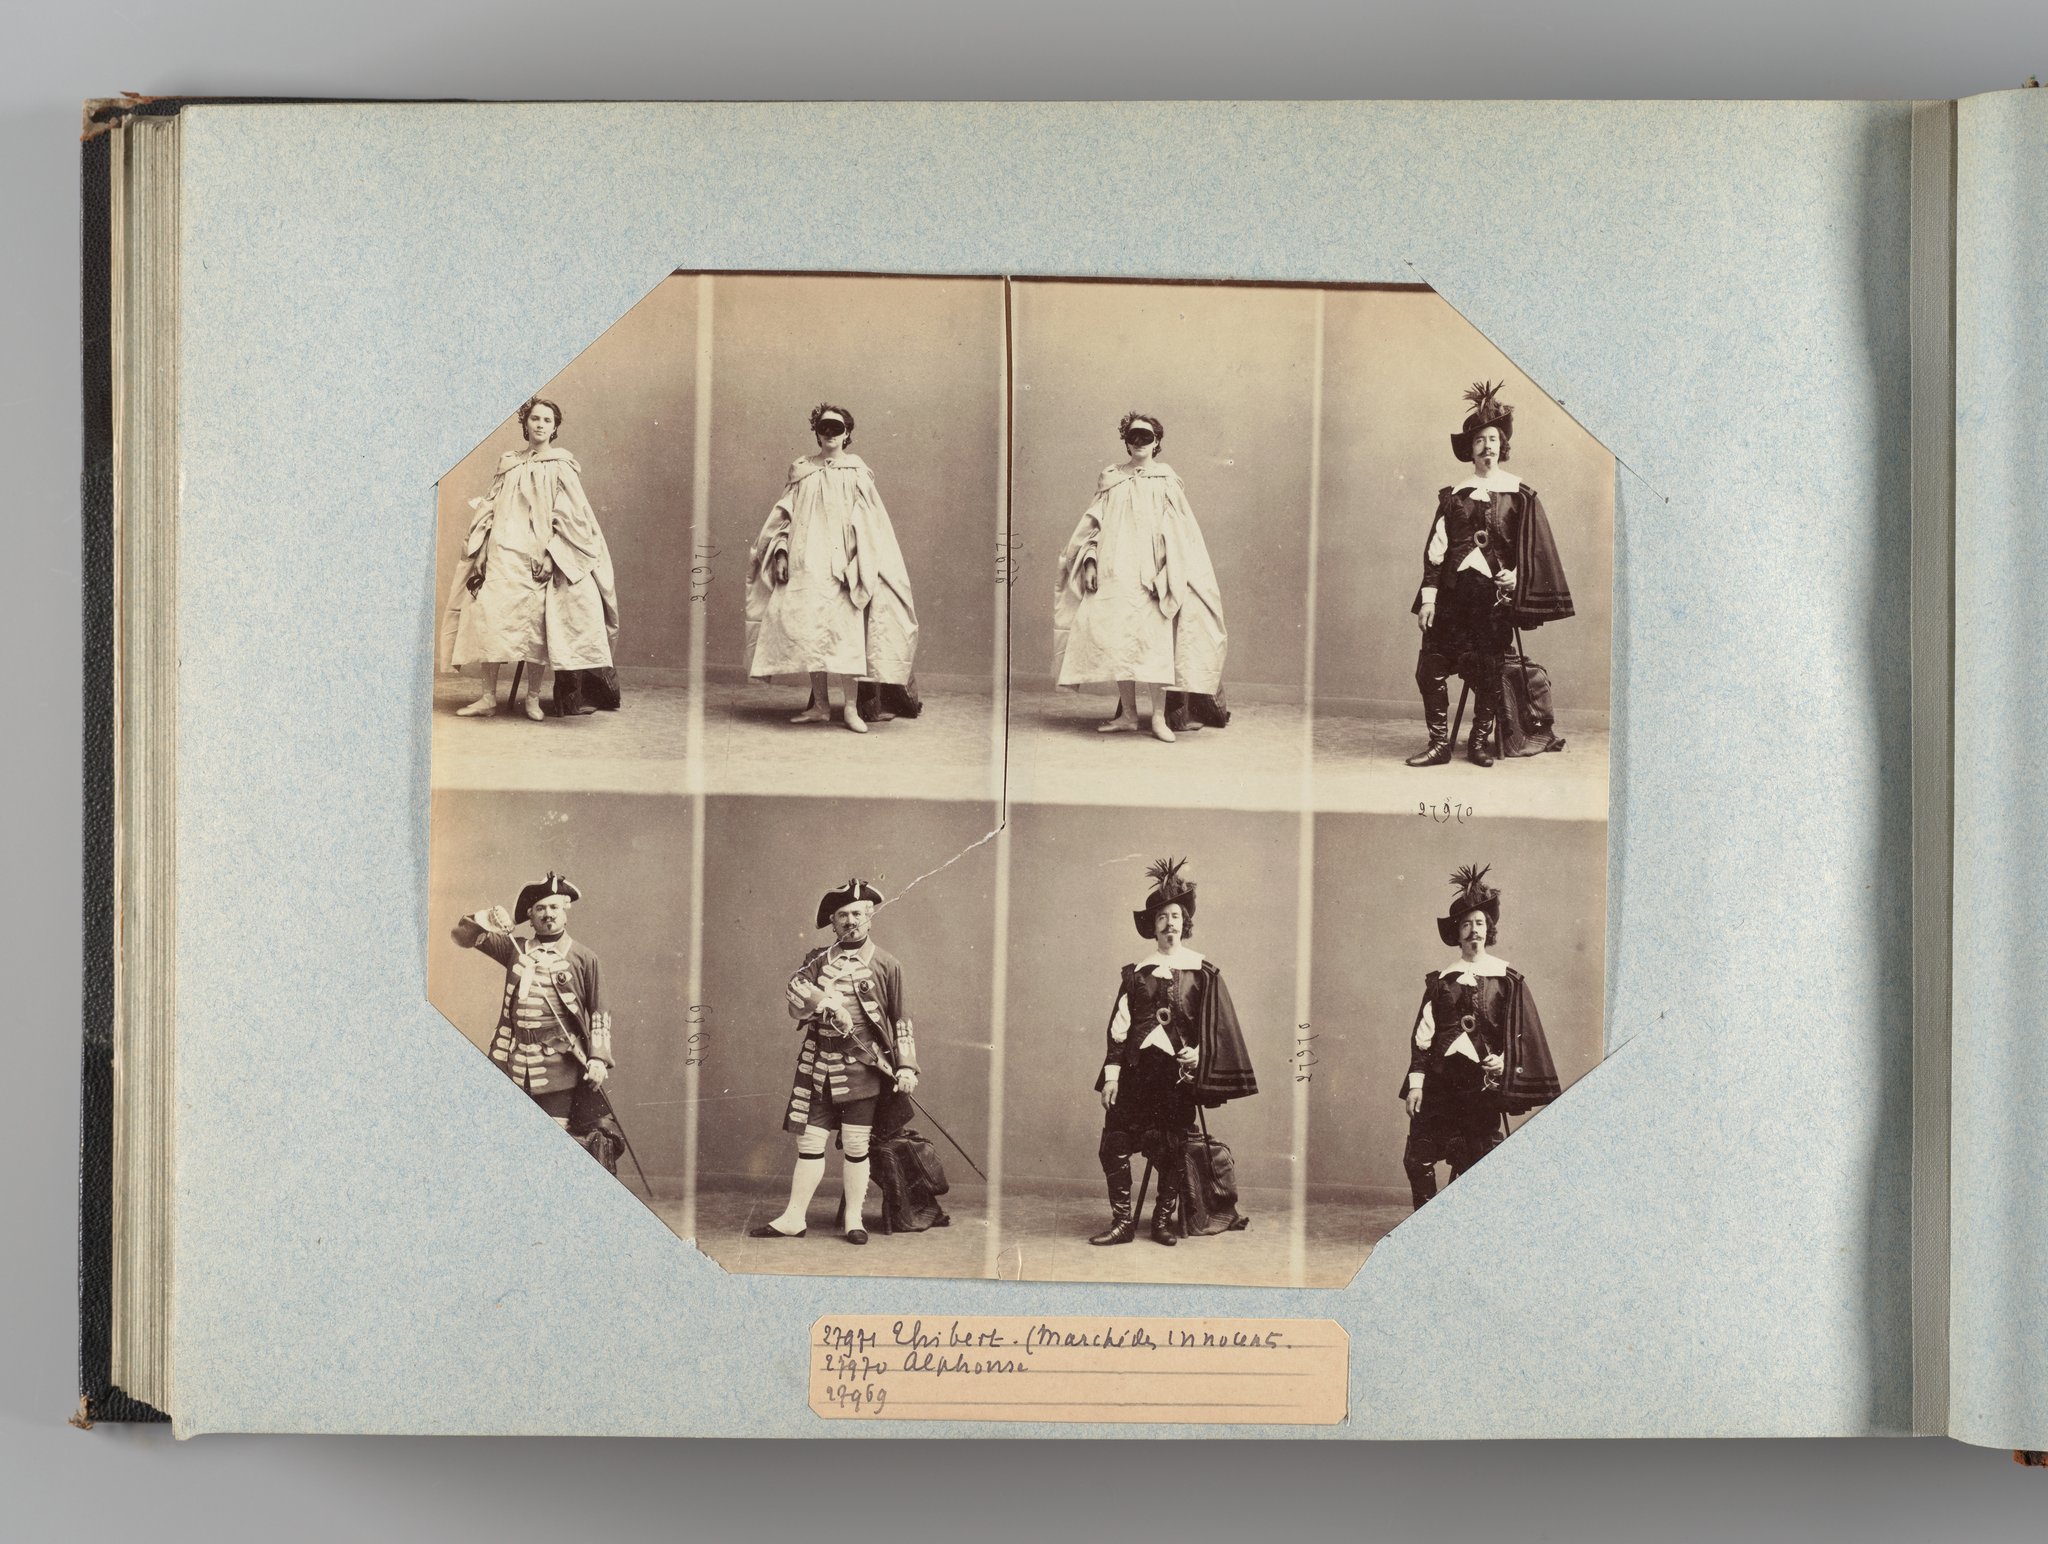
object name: photograph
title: Ghibert[?]; Alphonse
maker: andré-adolphe-eugène disdéri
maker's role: artist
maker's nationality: french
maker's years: 1819-1889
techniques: albumen silver print, glass negative